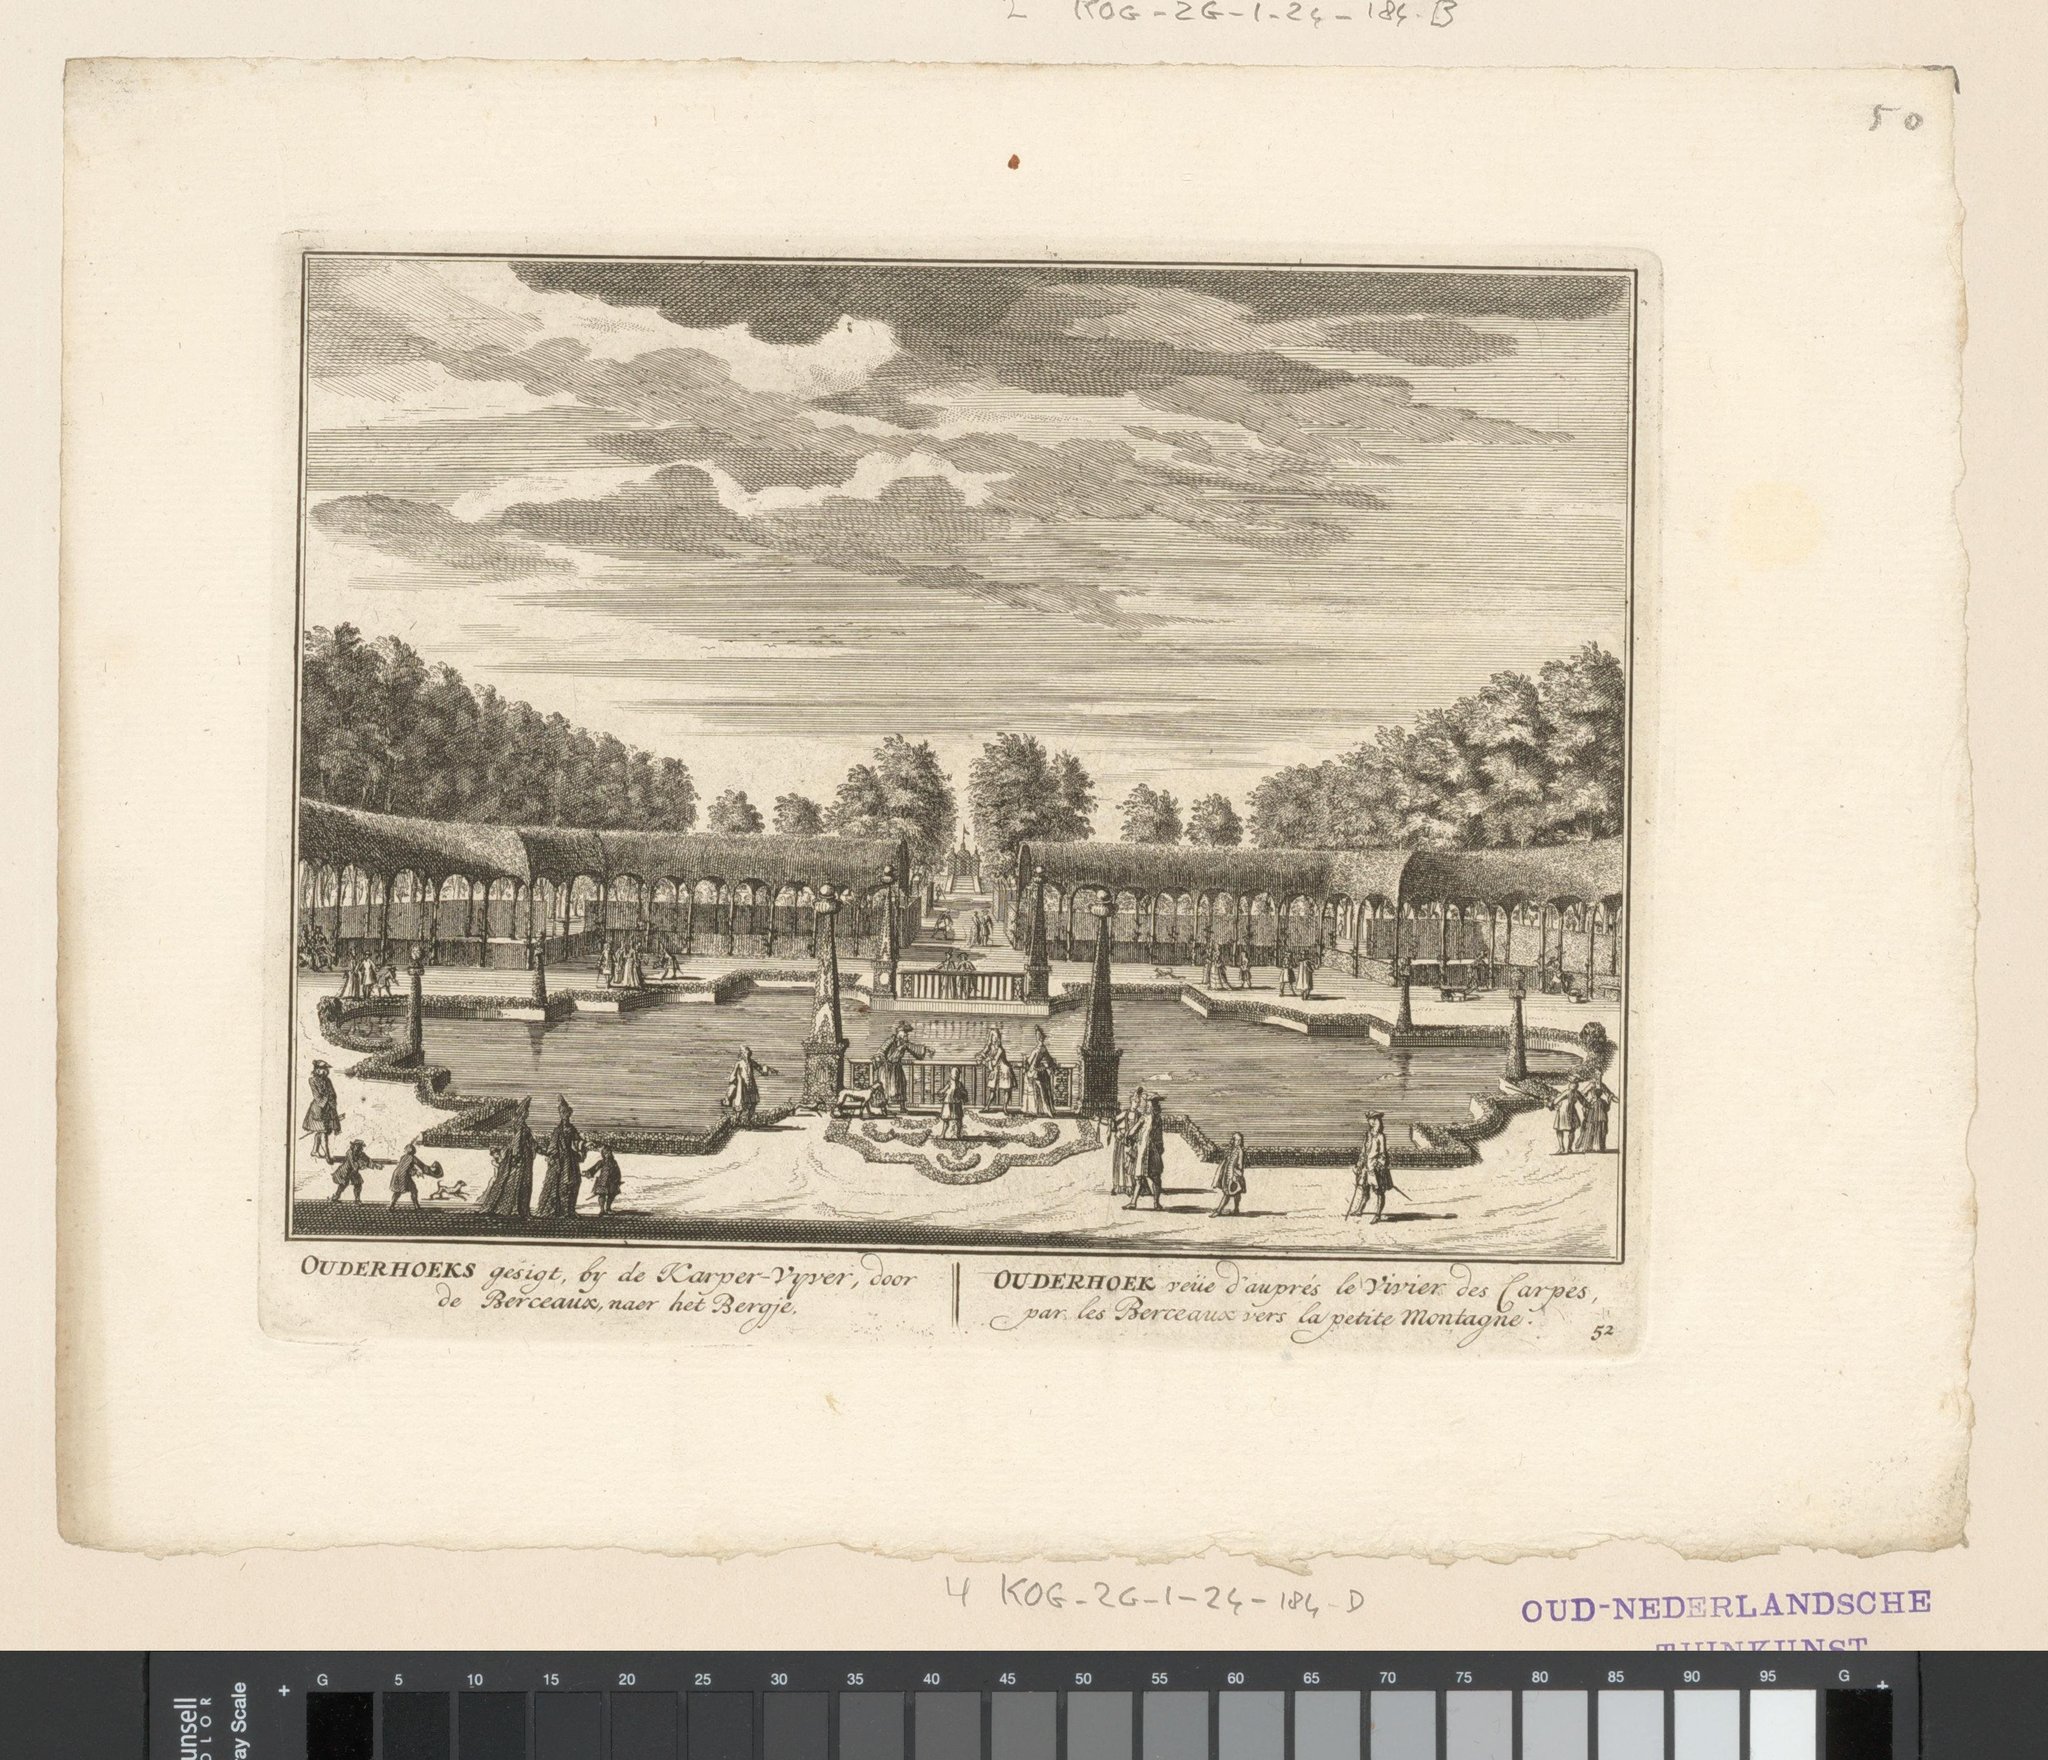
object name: print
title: Gezicht op de karpervijver en pergola van Buitenplaats Ouderhoek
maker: hendrik de leth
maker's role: draughtsman, print maker, publisher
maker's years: 1703-1766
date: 1729-1732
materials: paper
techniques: engraving, etching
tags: french or architectonic garden; formal garden, garden pond, country-house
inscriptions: stamp, stamp, collector's mark: Lugt 1641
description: Prent mogelijk uit: Brouërius van Nidek, Matthaeus. Het zegepralend Kennemerland, vertoond in 100 heerlyke gezichten. Amsterdam: Jan Roman, s.a. Of uit: Brouërius van Nidek, Matthaeus. Het zegepralend Kennemerland, vertoond in veele heerlyke gezichten. Amsterdam: Andries en Hendrik de Leth, s.a [1729-1732]. Of uit: Brouërius van Nidek, Matthaeus. Het zegepralend Kennemerland, vertoond in veele heerlyke gezichten. Amsterdam: Jan Roman, s.a.